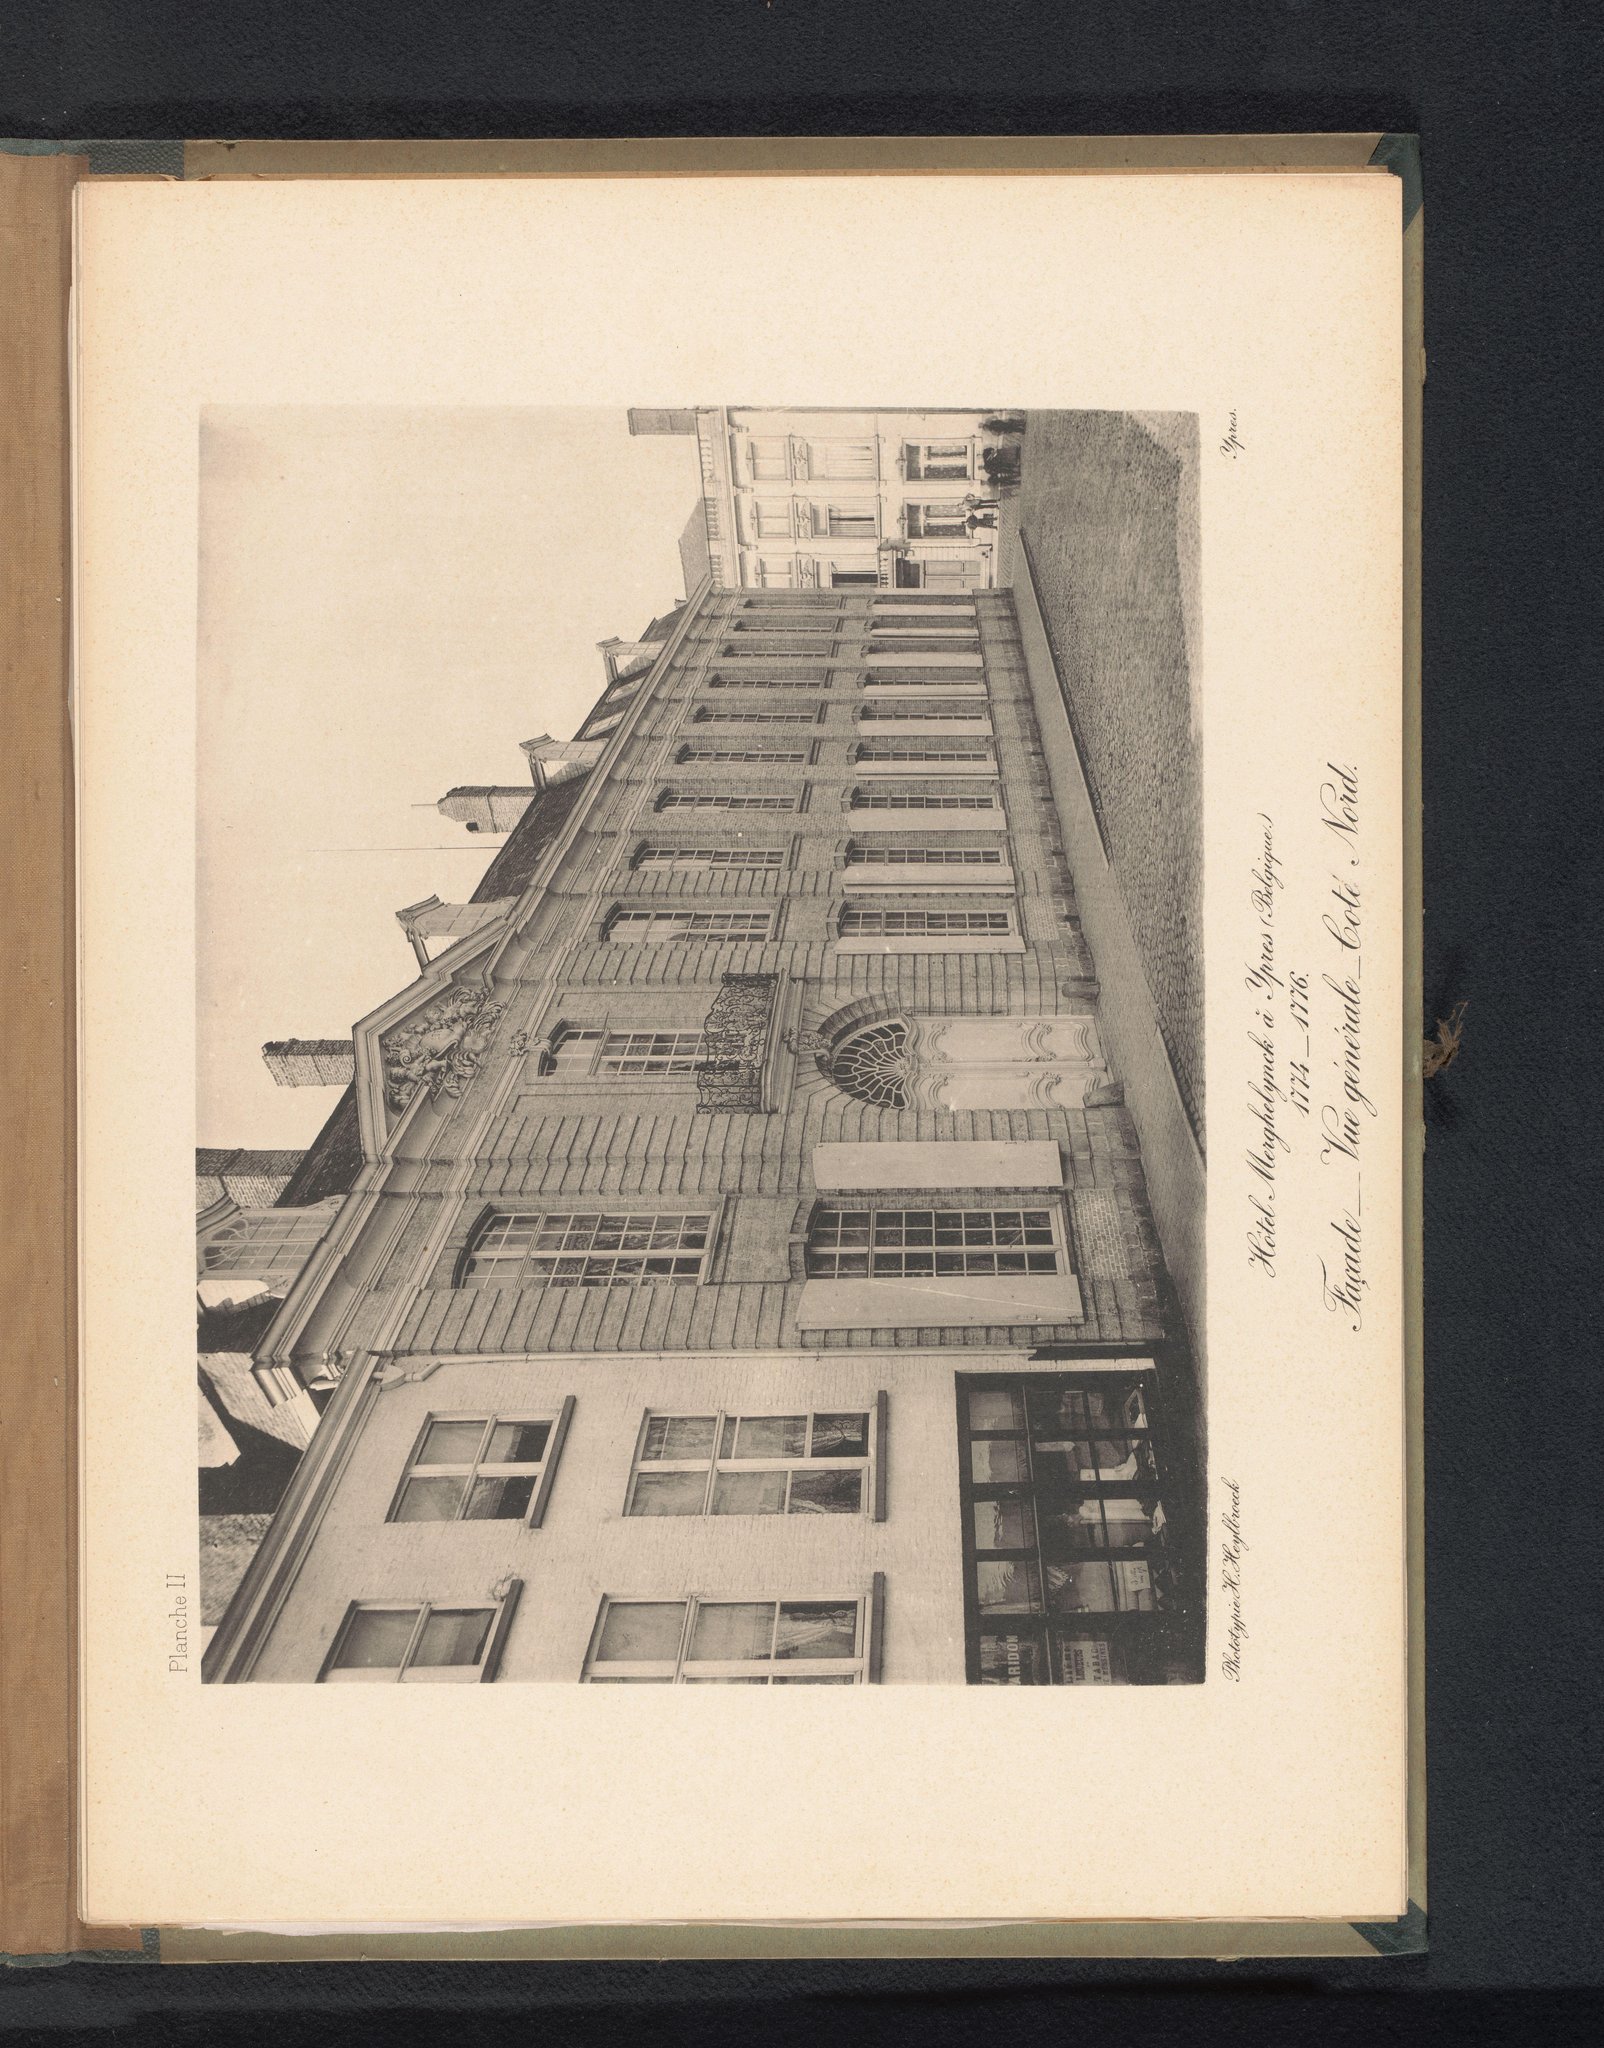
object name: photomechanical print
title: Gezicht op de noordelijke hoek van de façade van Hotel Merghelynck in Ieper, België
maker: hector heylbroeck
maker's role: fotograaf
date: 1889-1894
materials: paper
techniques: photograph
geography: ieper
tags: hotel, hostelry, inn, front façade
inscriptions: number: ‘Planche II’, inscription: ‘Ypres.’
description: Deze prent maakt deel uit van een omslag met 31 prenten en een katern met teksten.